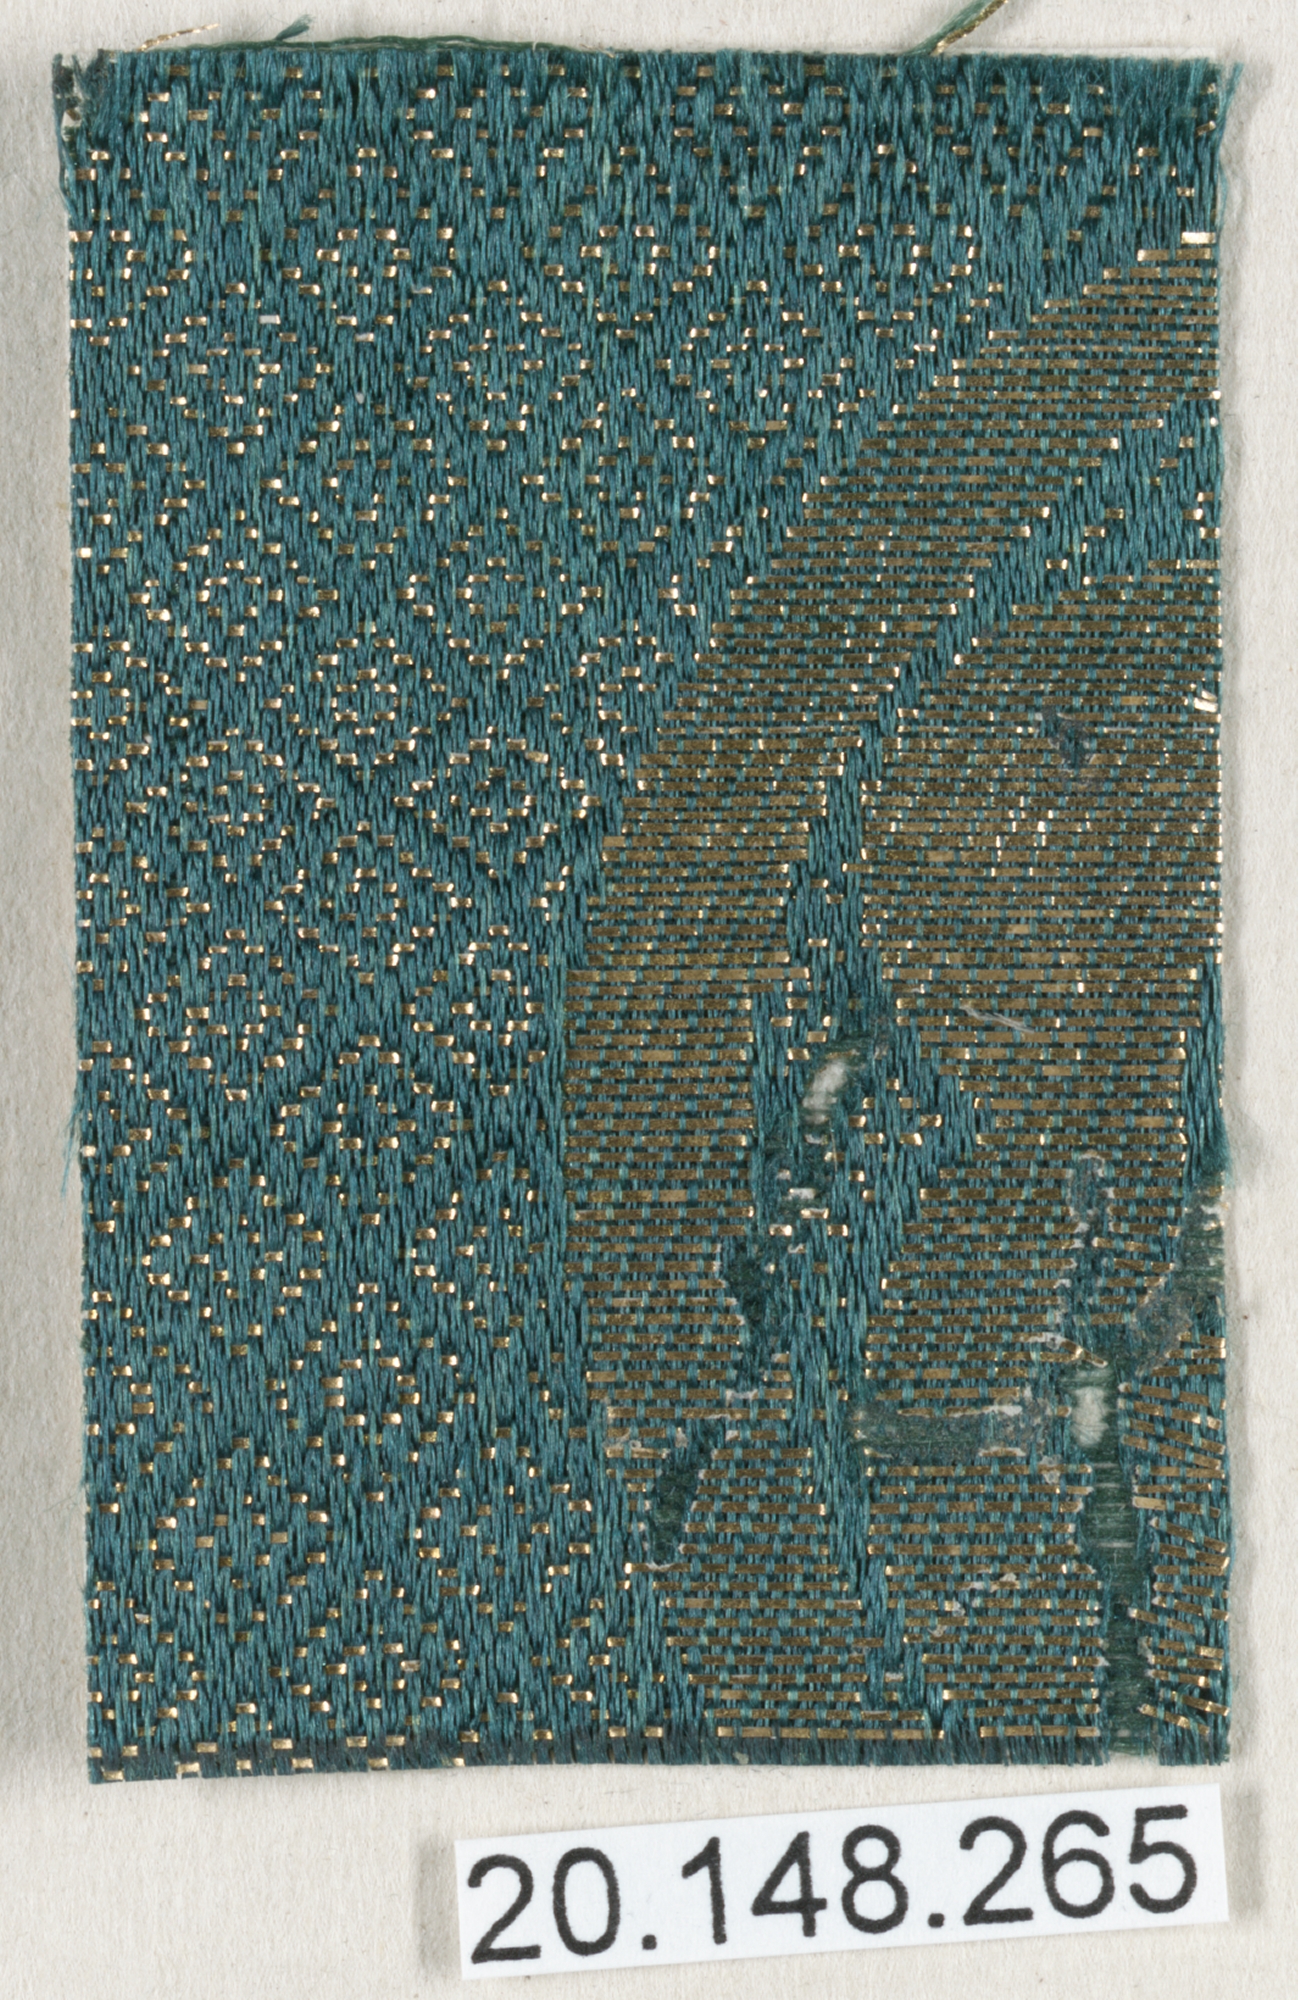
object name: piece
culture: japanese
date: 1701-1800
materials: silk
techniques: compound weave